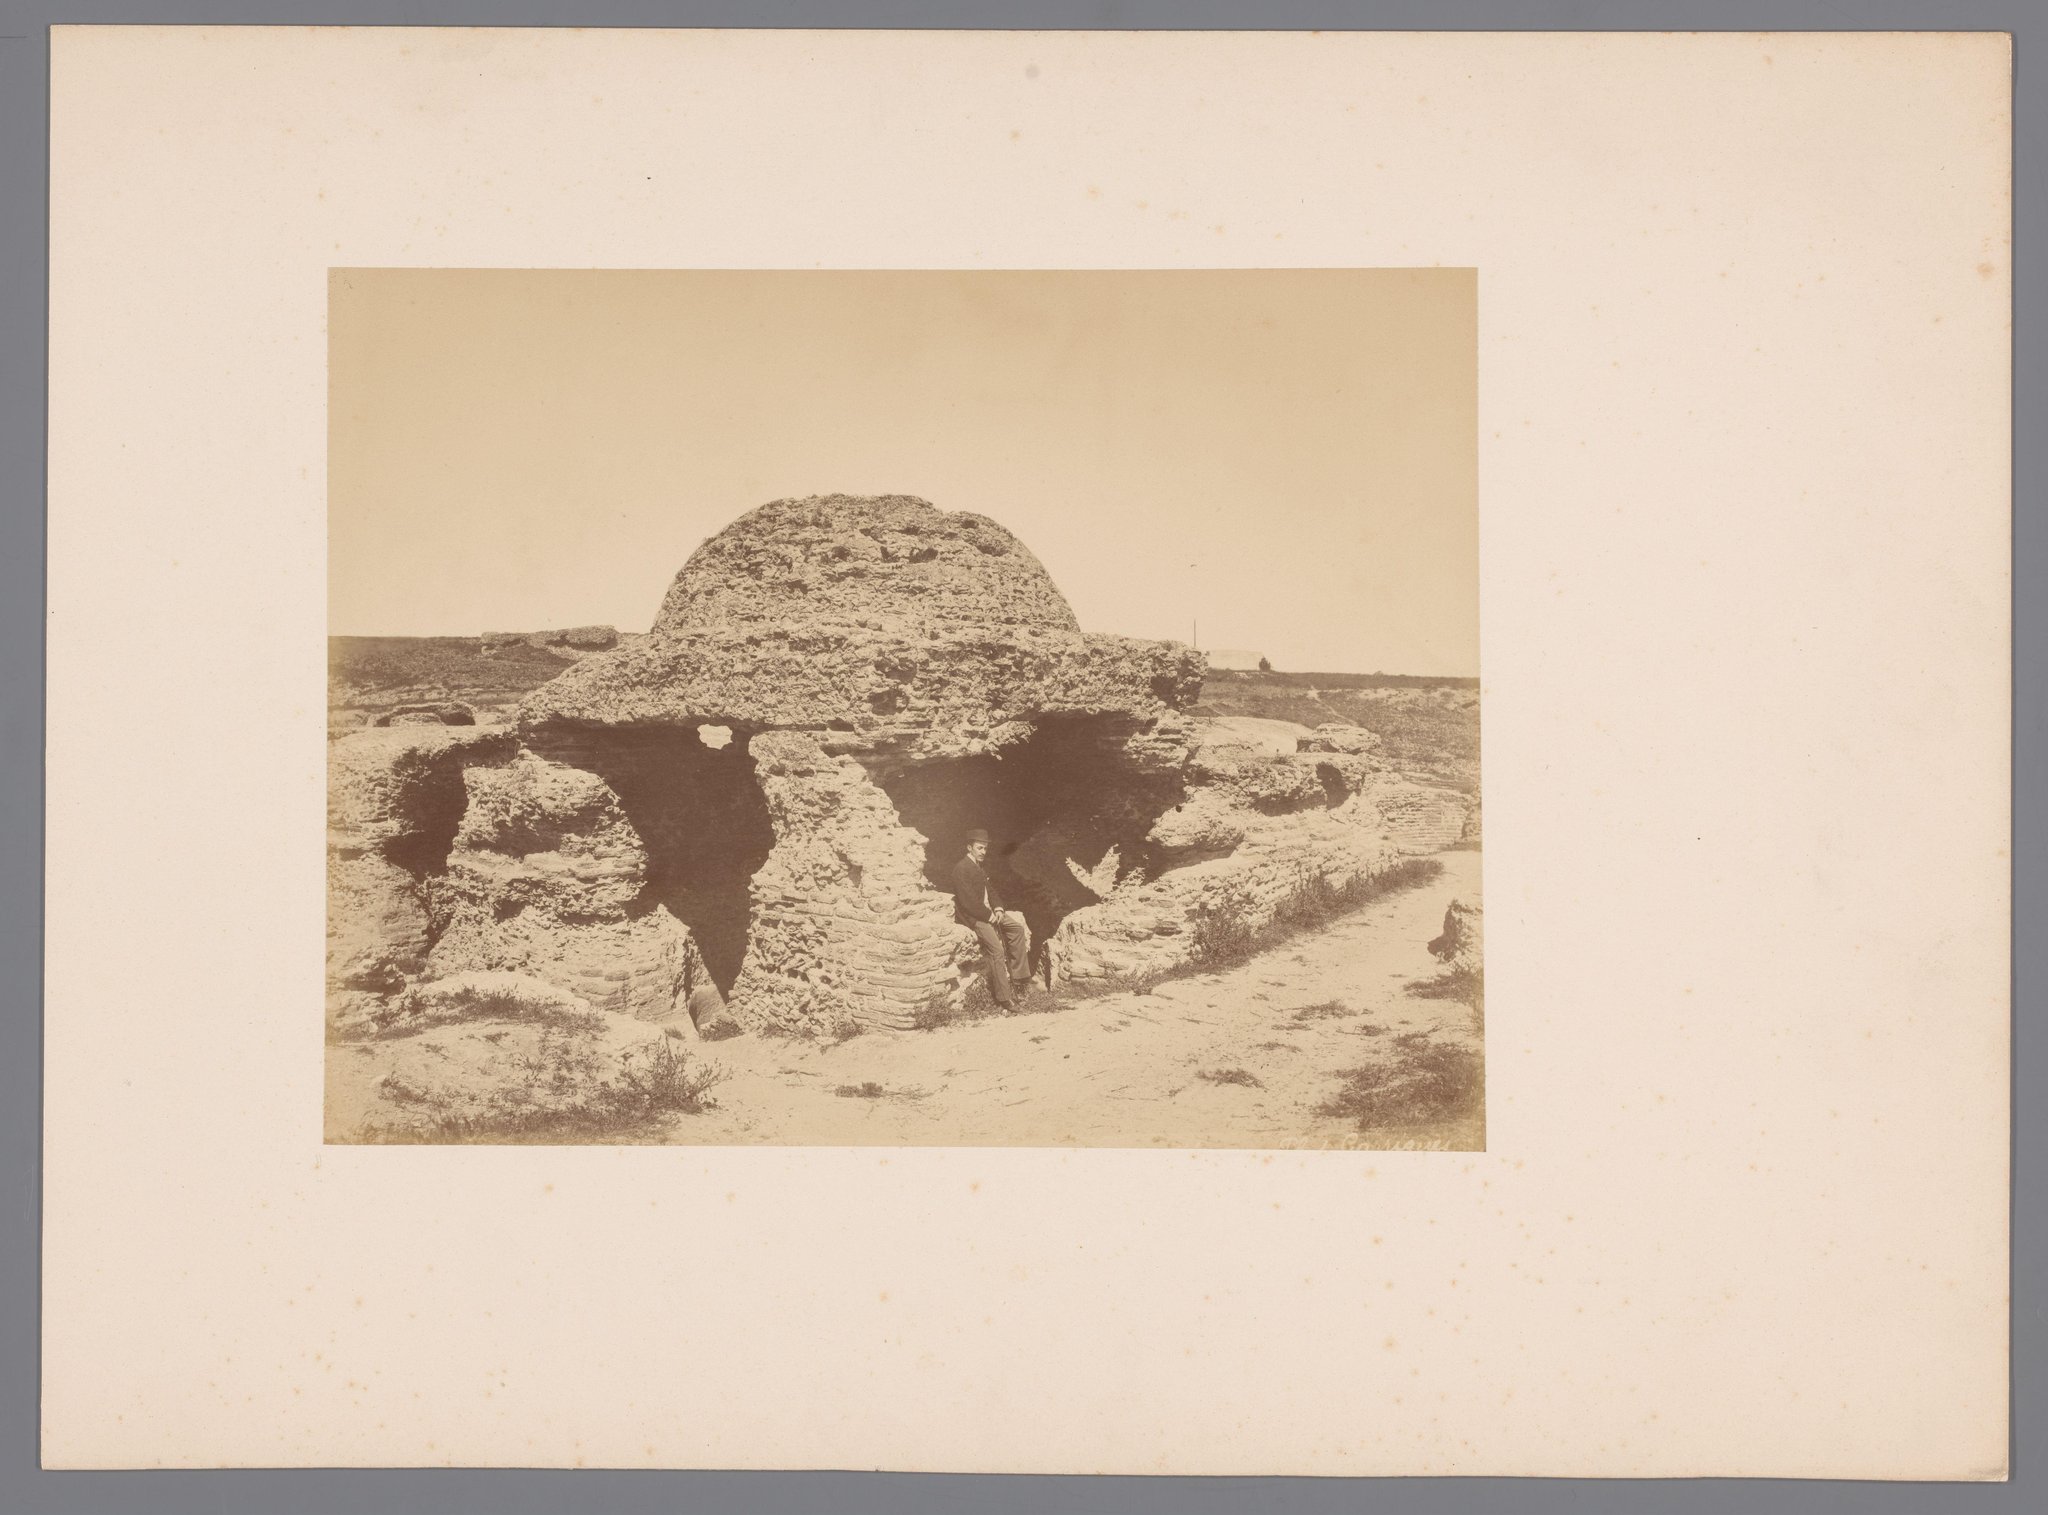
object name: photograph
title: Overkapping/huis van plaatstenen [?], met een man ervoor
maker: Anonymous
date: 1870-1900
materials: cardboard, paper, photographic support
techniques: albumen print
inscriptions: inscription: ‘Ph. J Carrianes [?]’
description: Overkapping/huis van plaatstenen [?], met een man ervoor.